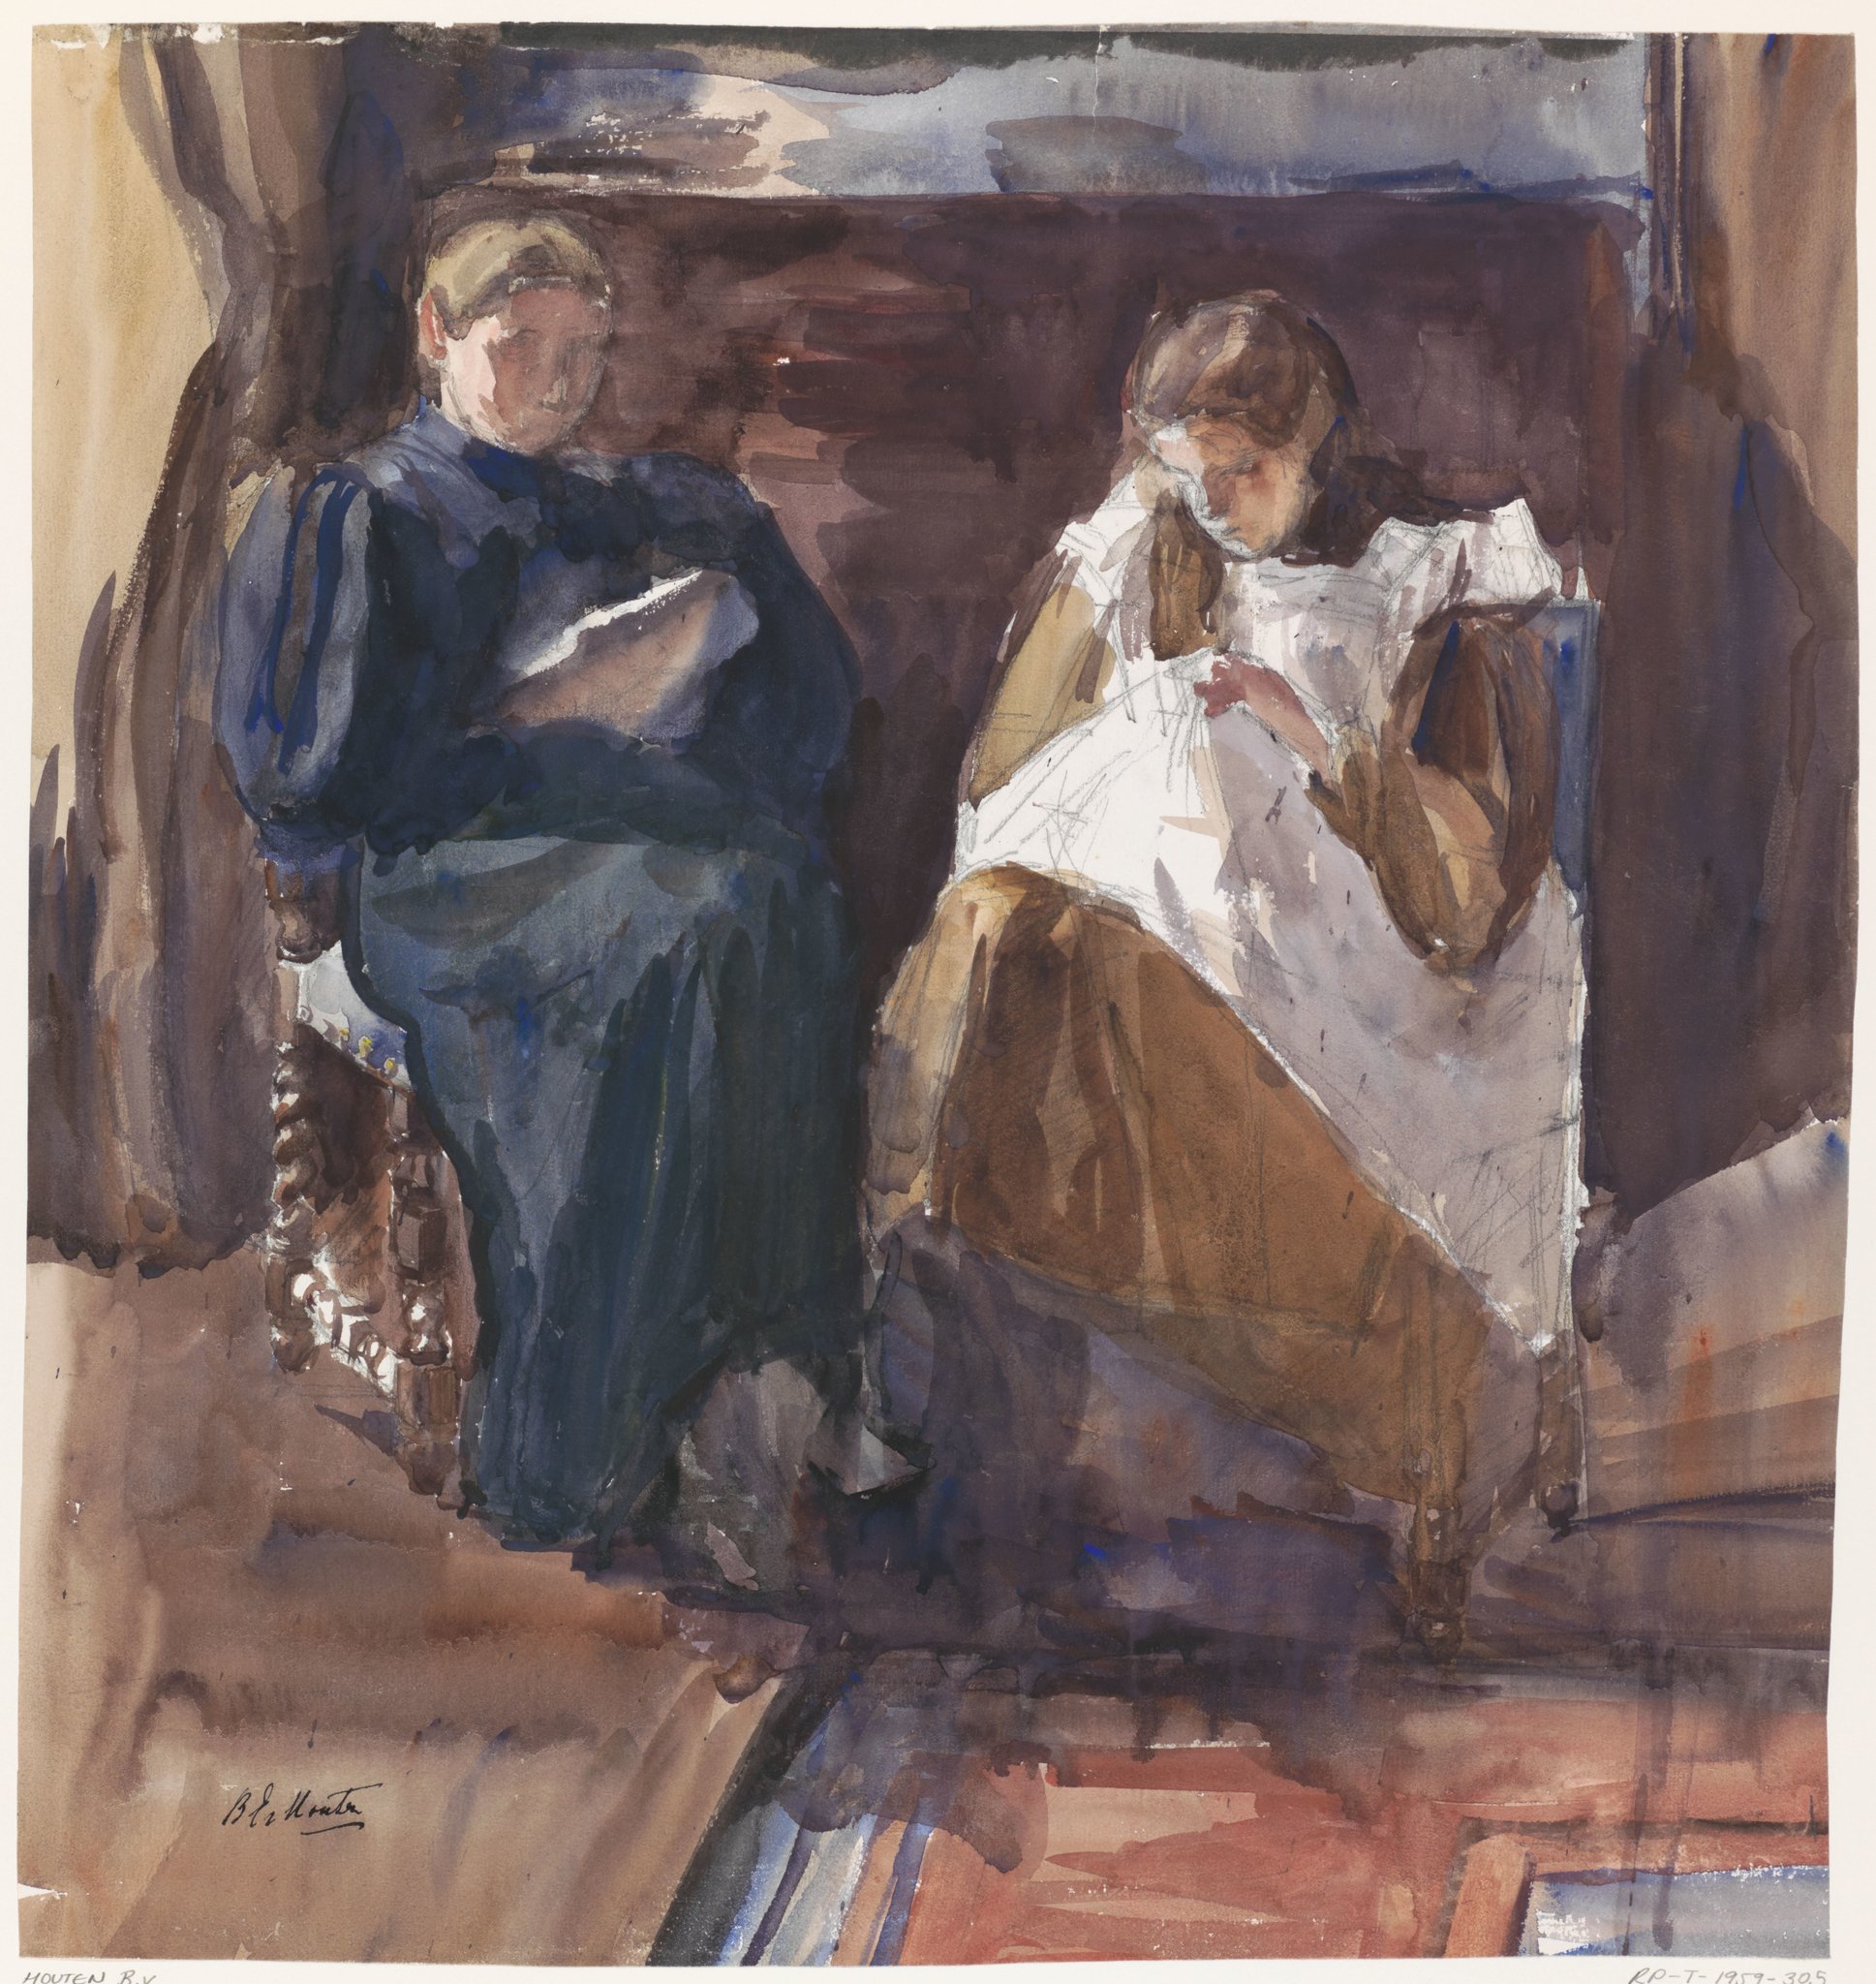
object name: watercolor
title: Lezende dame en bordurend meisje, van voren gezien, in het huis aan de Riouwstraat 6, te Den Haag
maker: barbara elisabeth van houten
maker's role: draughtsman, print maker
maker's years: 1862-1950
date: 1872-1950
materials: paper, pencil, watercolor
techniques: brush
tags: reading, sun-porch, sun-parlour, glazed verandah, girl (child between toddler and youth), (other forms of) needlework, e.g.: crocheting, knitting, embroidering, male sex; man, the hague